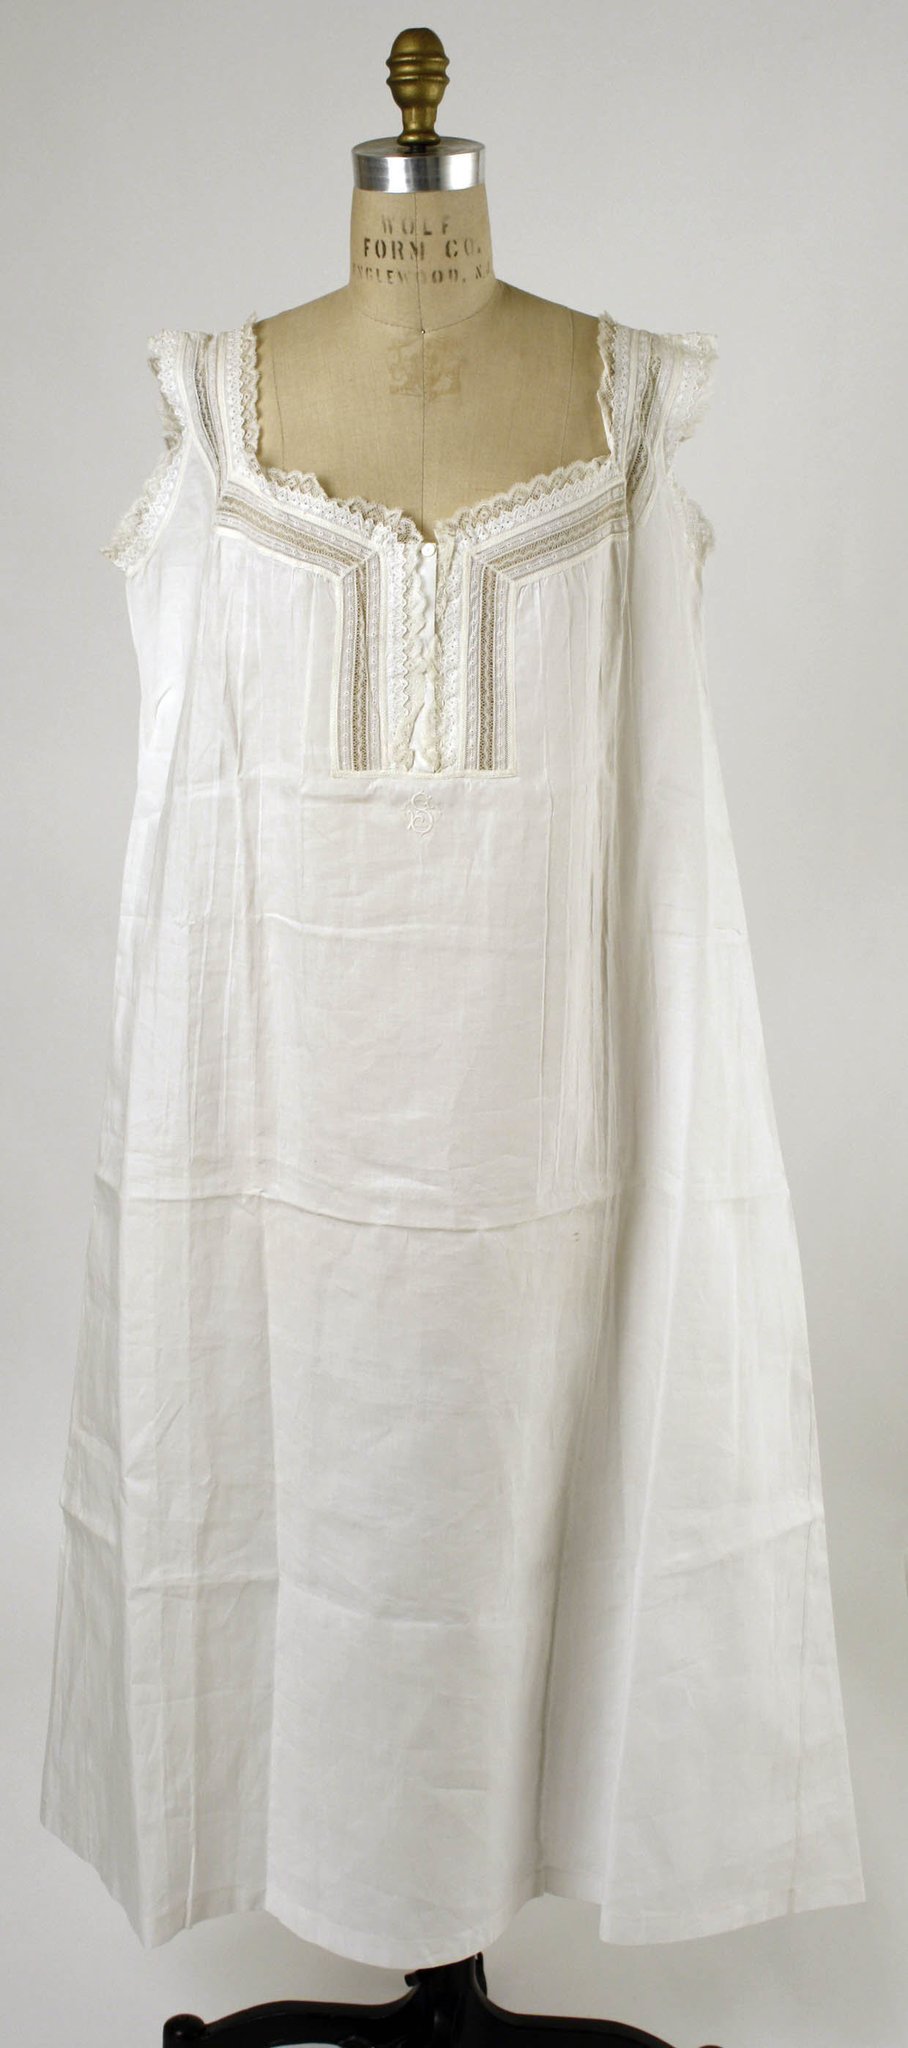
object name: chemise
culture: american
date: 1880-1889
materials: linen